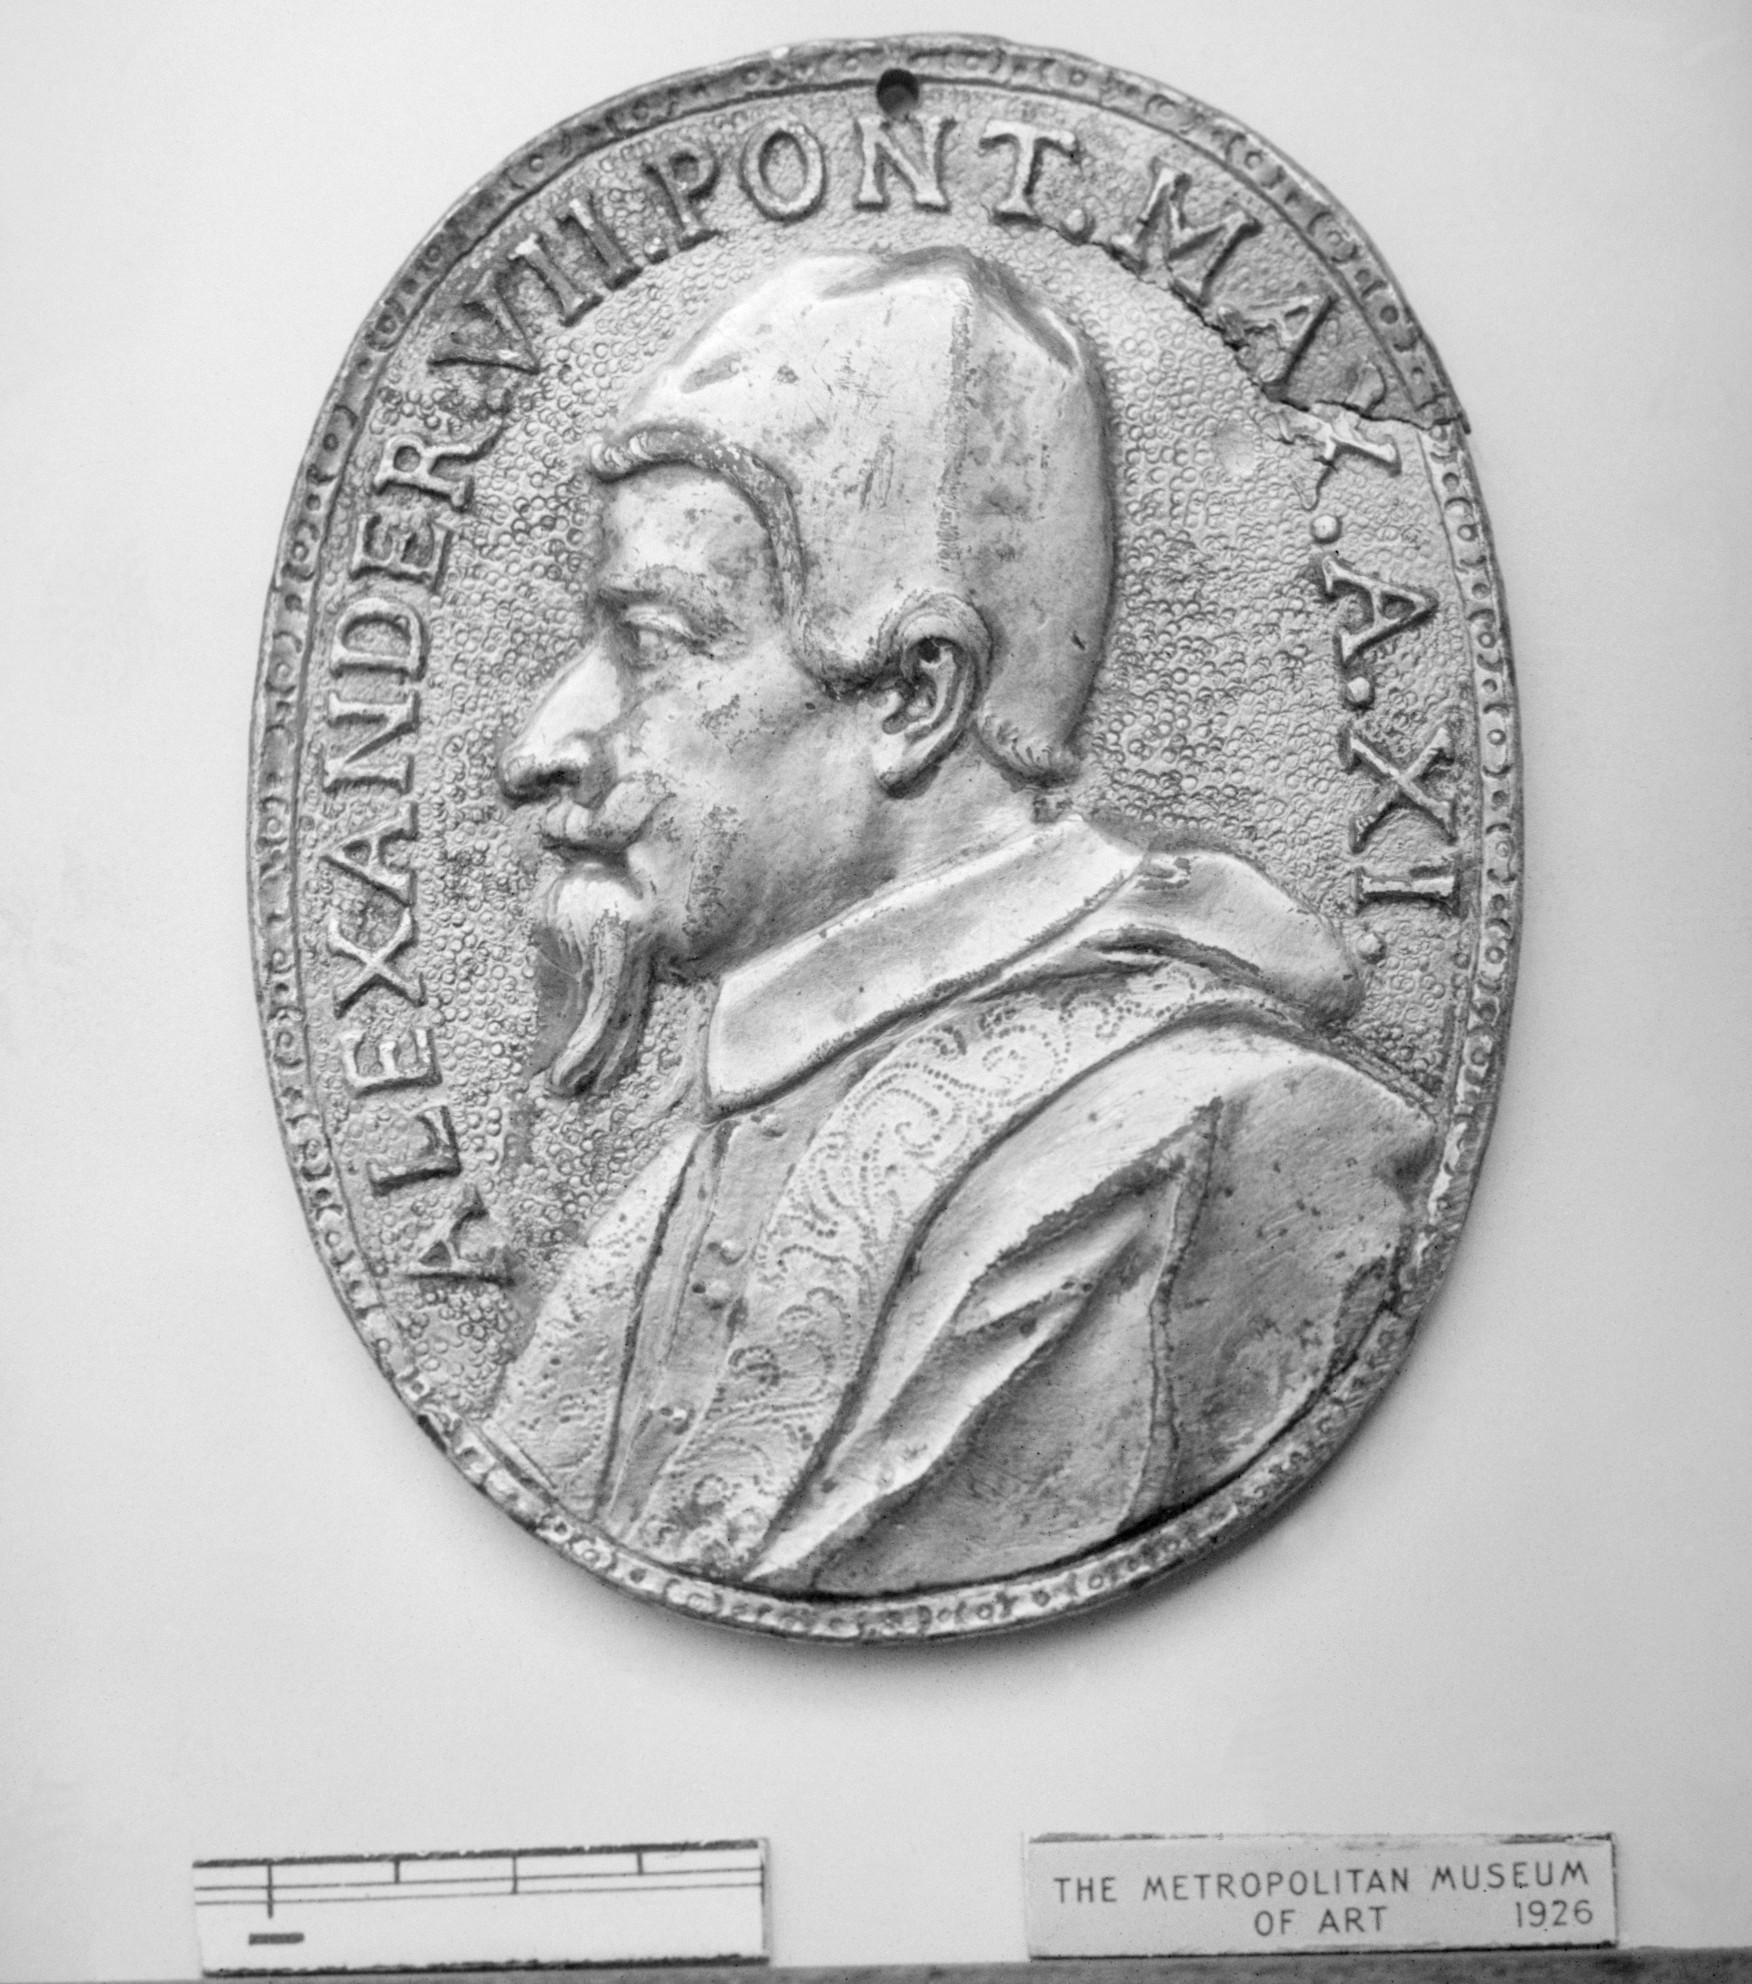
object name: medal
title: Pope Alexander VII (Fabio Chigi), (b. 1599, Pope 1655–67)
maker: gasparo morone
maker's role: artist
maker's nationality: italian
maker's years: 1569-1669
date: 1665-1666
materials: gilt bronze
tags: profiles,popes,coat of arms